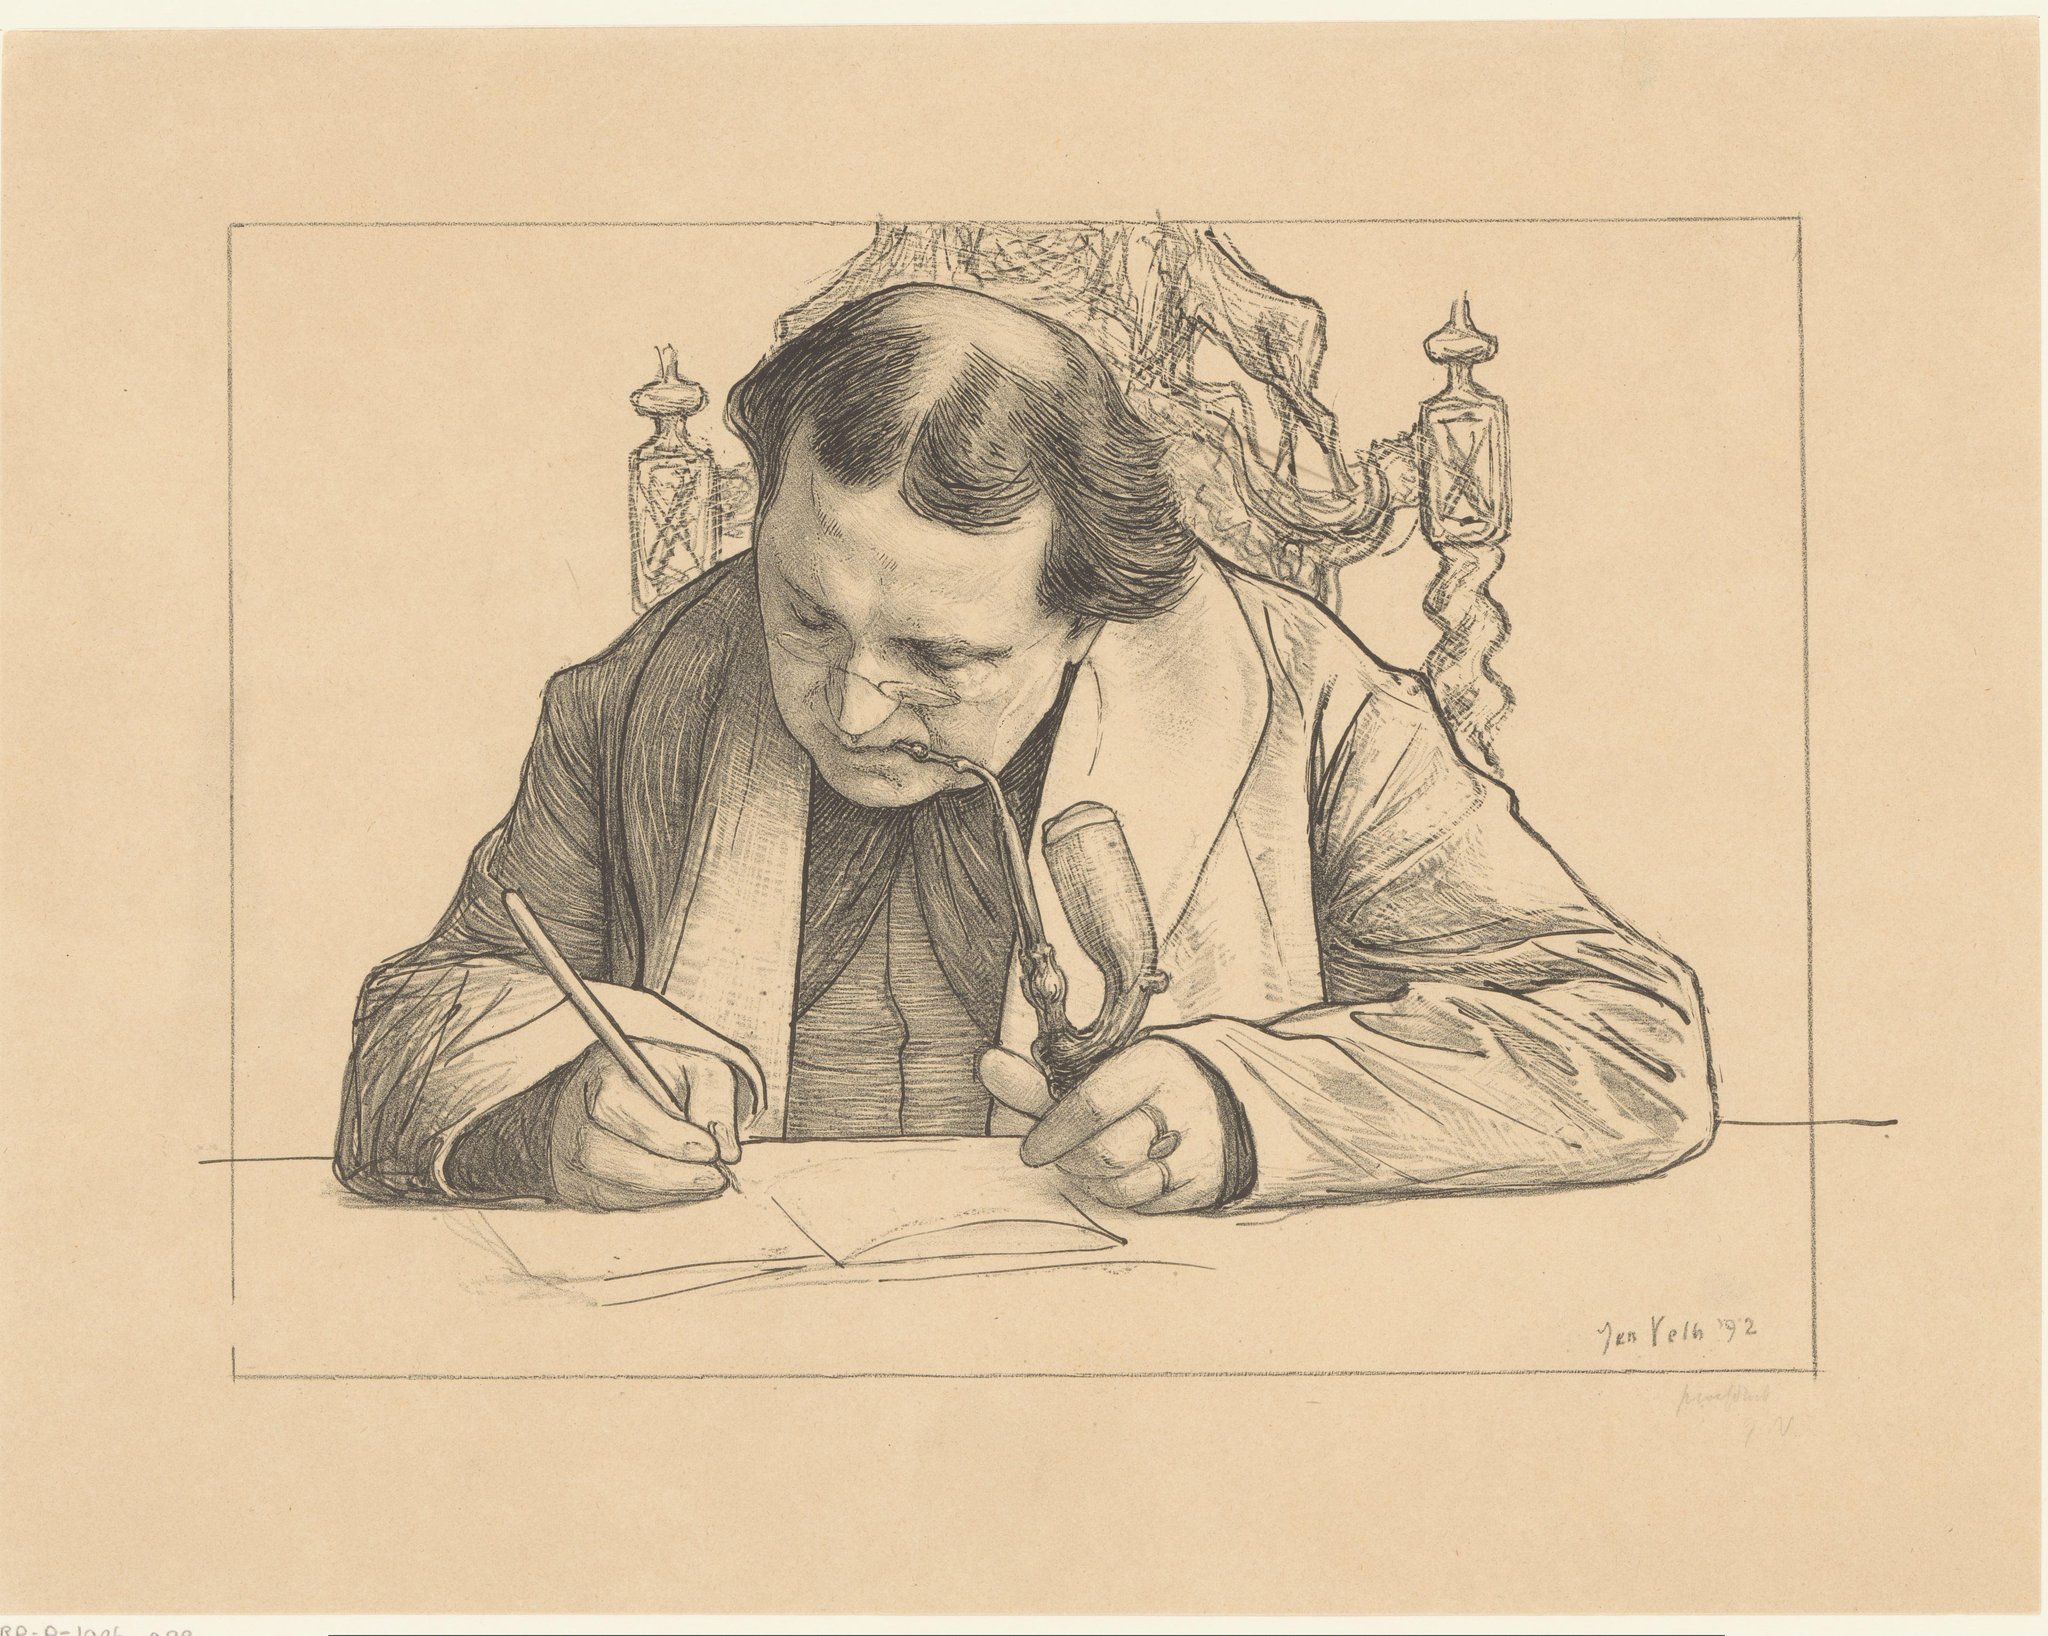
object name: print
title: Bekende tijdgenooten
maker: jan veth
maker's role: designer, draughtsman, painter, print maker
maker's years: 1864-1925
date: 1892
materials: paper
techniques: lithograph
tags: the hague, abraham kuyper, writing tools, pipe ~ tobacco, historical persons (+ (full) bust portrait)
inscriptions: inscription: ‘Proefdruk / JV’, collector's mark: Lugt 2228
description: Deze prent werd uitgegeven bij De Amsterdammer op 17 januari 1892.